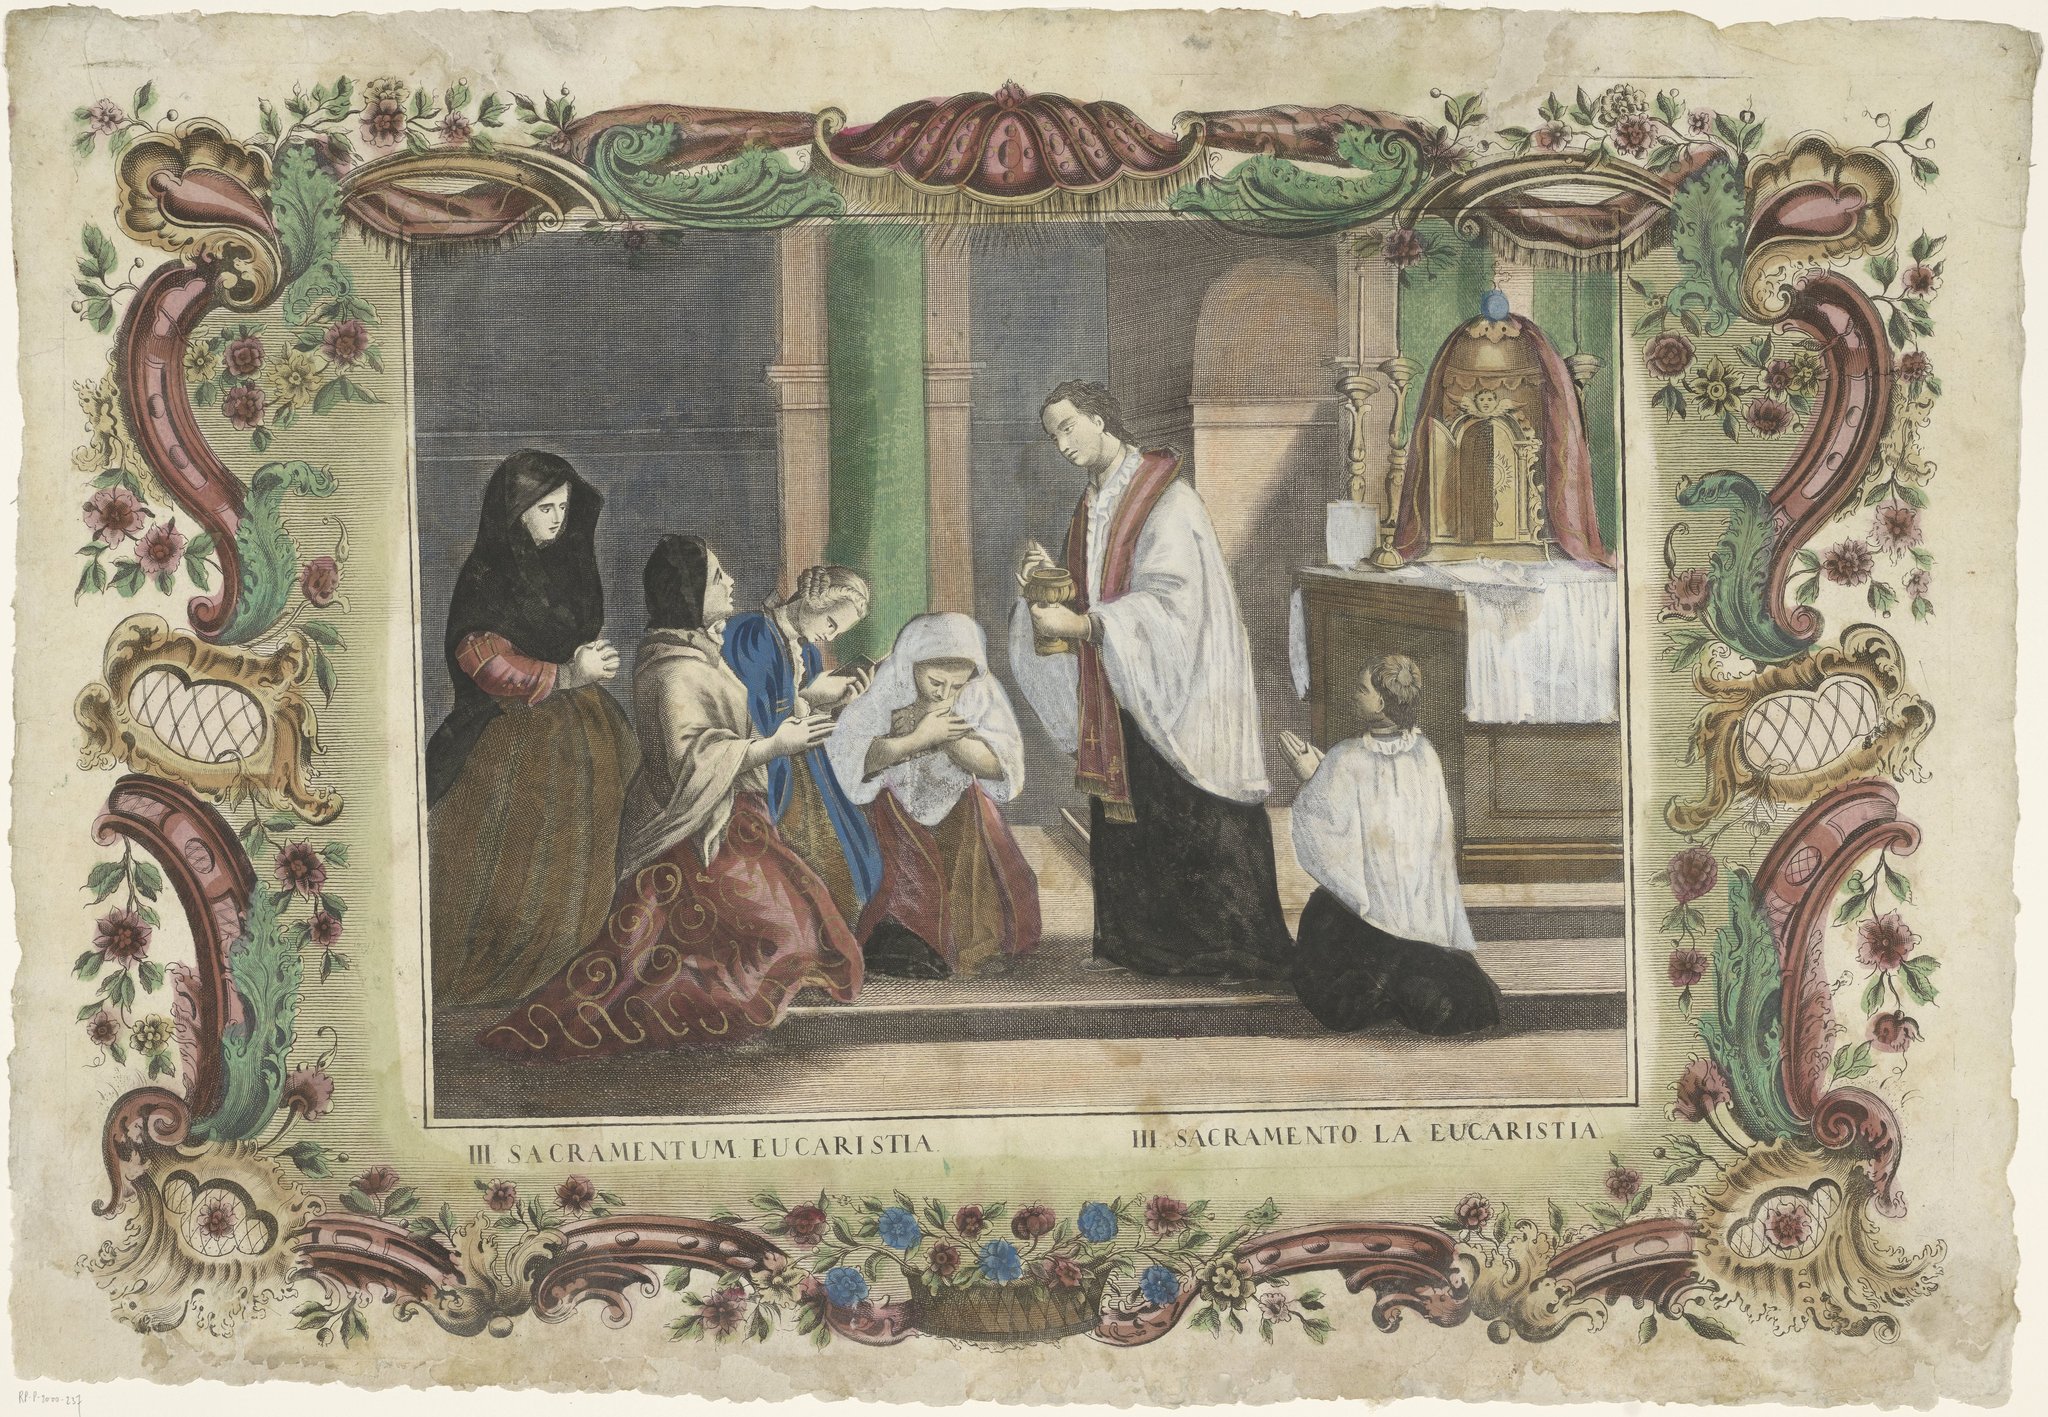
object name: print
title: De zeven sacramenten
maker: giovanni volpato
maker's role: ceramicist, print maker, printer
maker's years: 1735-1803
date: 1700-1799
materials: paper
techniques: colour, engraving, etching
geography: bassano del grappa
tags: ornaments ~ art, the eucharist ~ the fourth of the seven sacraments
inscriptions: collector's mark: Lugt 2228, collector's mark: Lugt 2760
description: Het sacrament van de eucharistie. In een kerk staat een priester met kelk en hostie in de handen. Drie knielende dames en een heer gaan bij hem te communie. Rechtsvoor een knielende misdienaar. Rechtsachter een altaar. Titel in twee talen onder voorstelling. De scène is gevat in een ornamentrand.